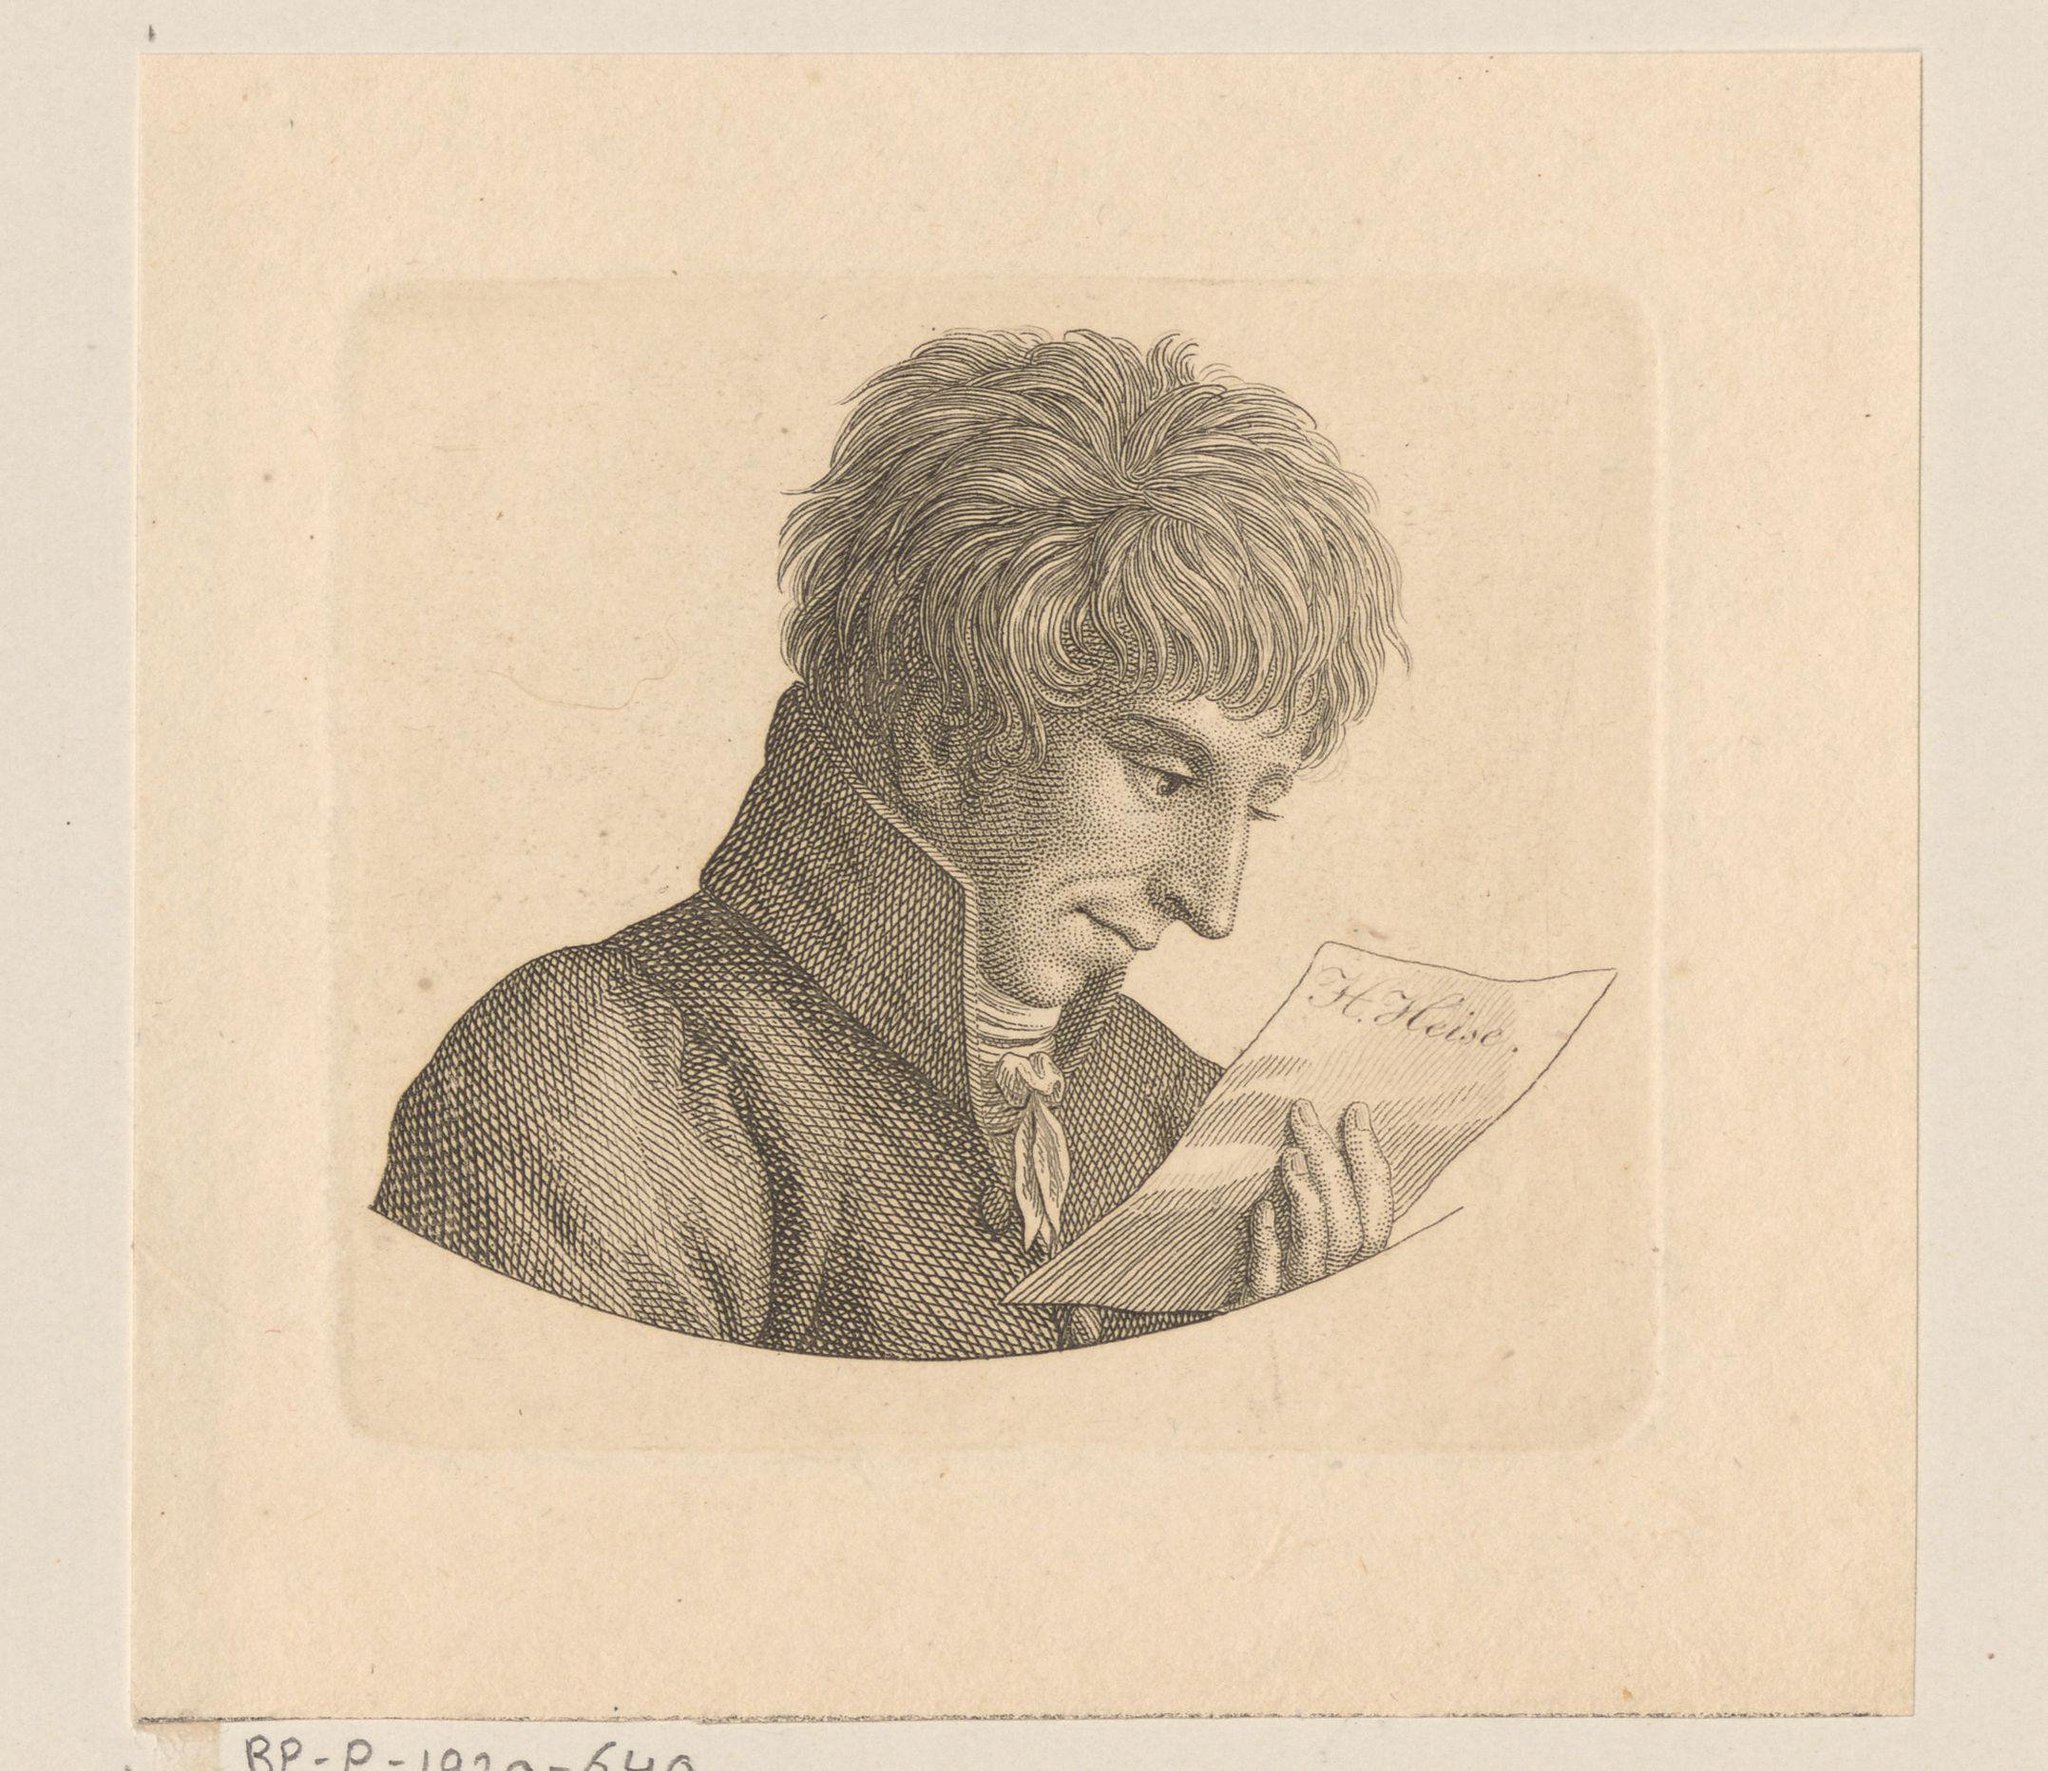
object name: print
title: Portret van mogelijk Heinrich Heine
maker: Anonymous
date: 1825-1849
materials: paper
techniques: etching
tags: paris, heinrich heine, historical persons, portrait of a writer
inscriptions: collector's mark: Lugt 2228